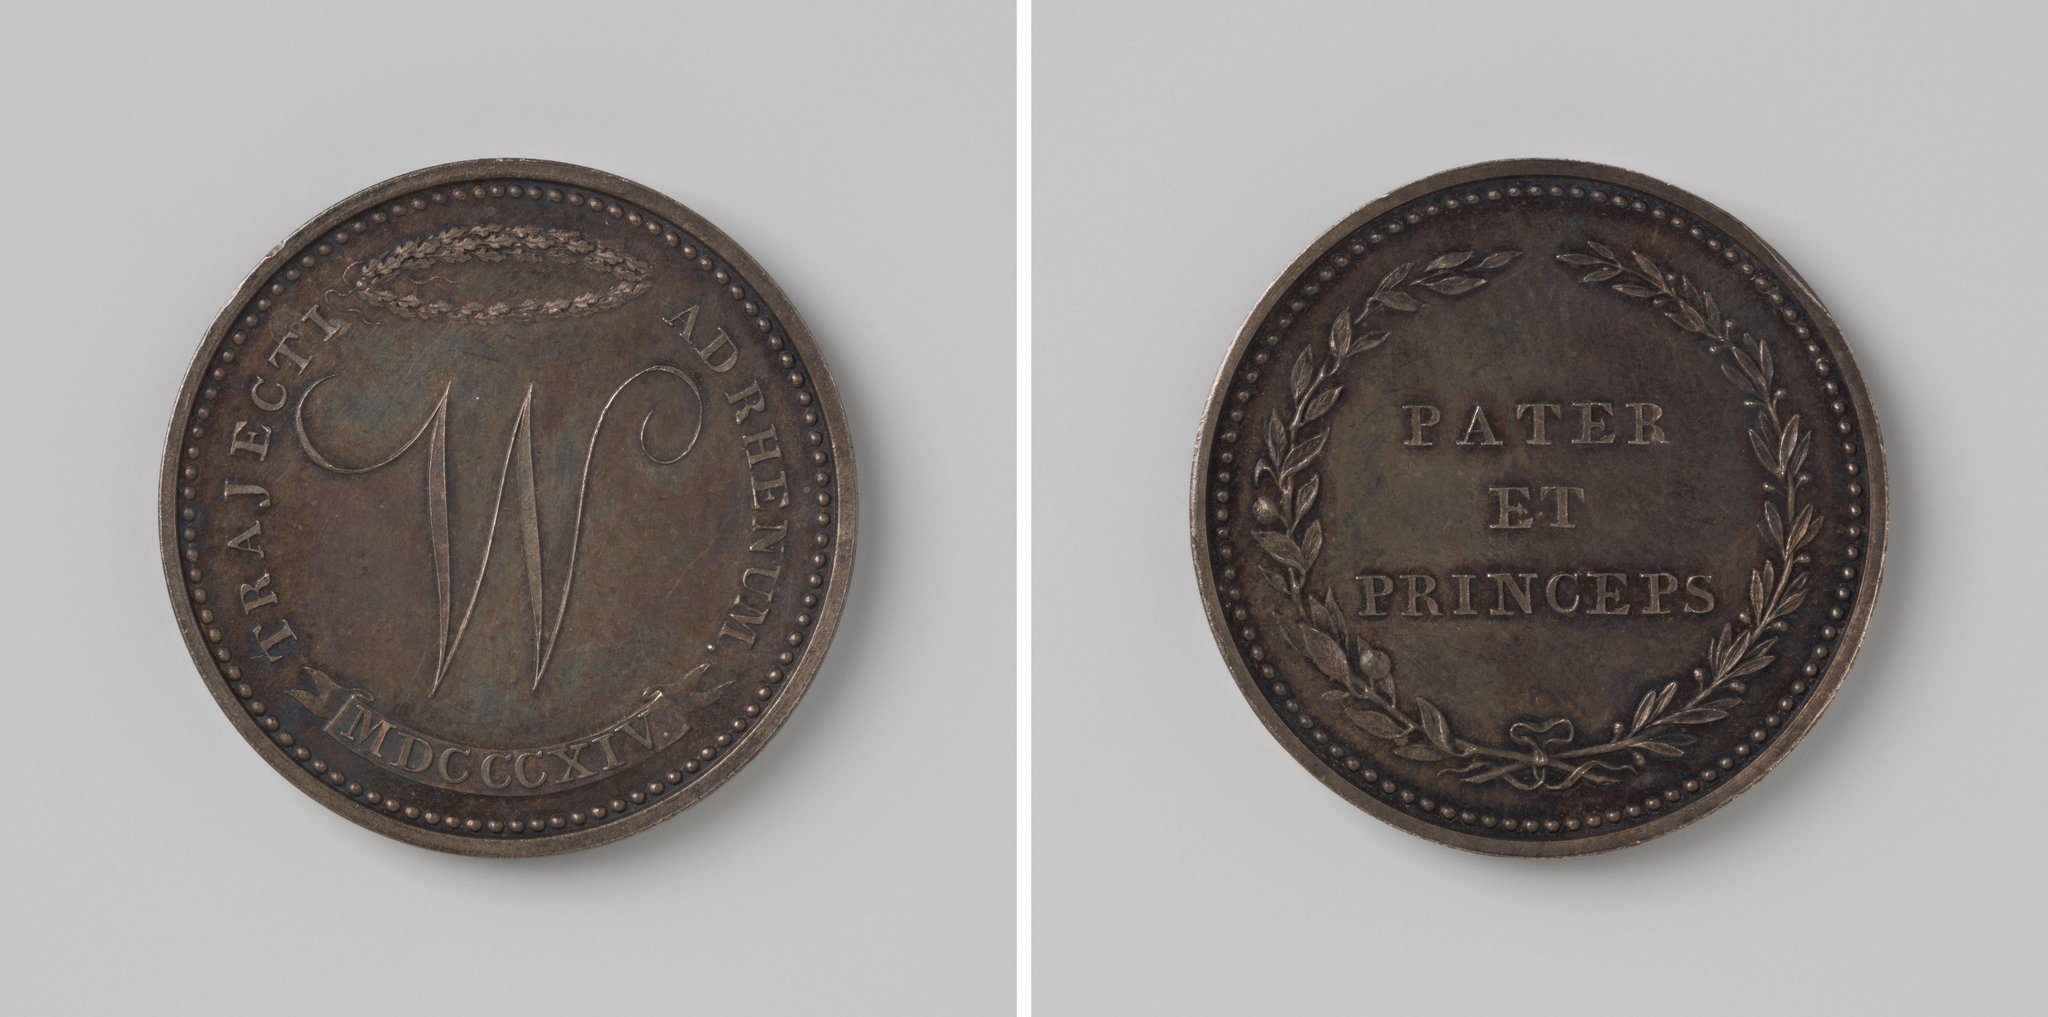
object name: history medal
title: Bezoek van Willem Frederik, souverein vorst der Nederlanden aan de munt van Utrecht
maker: david van der kellen (1764-1825)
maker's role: die cutter, draughtsman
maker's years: 1764-1825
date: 1814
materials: silver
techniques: striking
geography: utrecht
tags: william i of the netherlands, utrecht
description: Zilveren penning. Voorzijde: hoofdletter W onder eikekrans binnen omschrift. Keerzijde: opschrift binnen olijfkrans